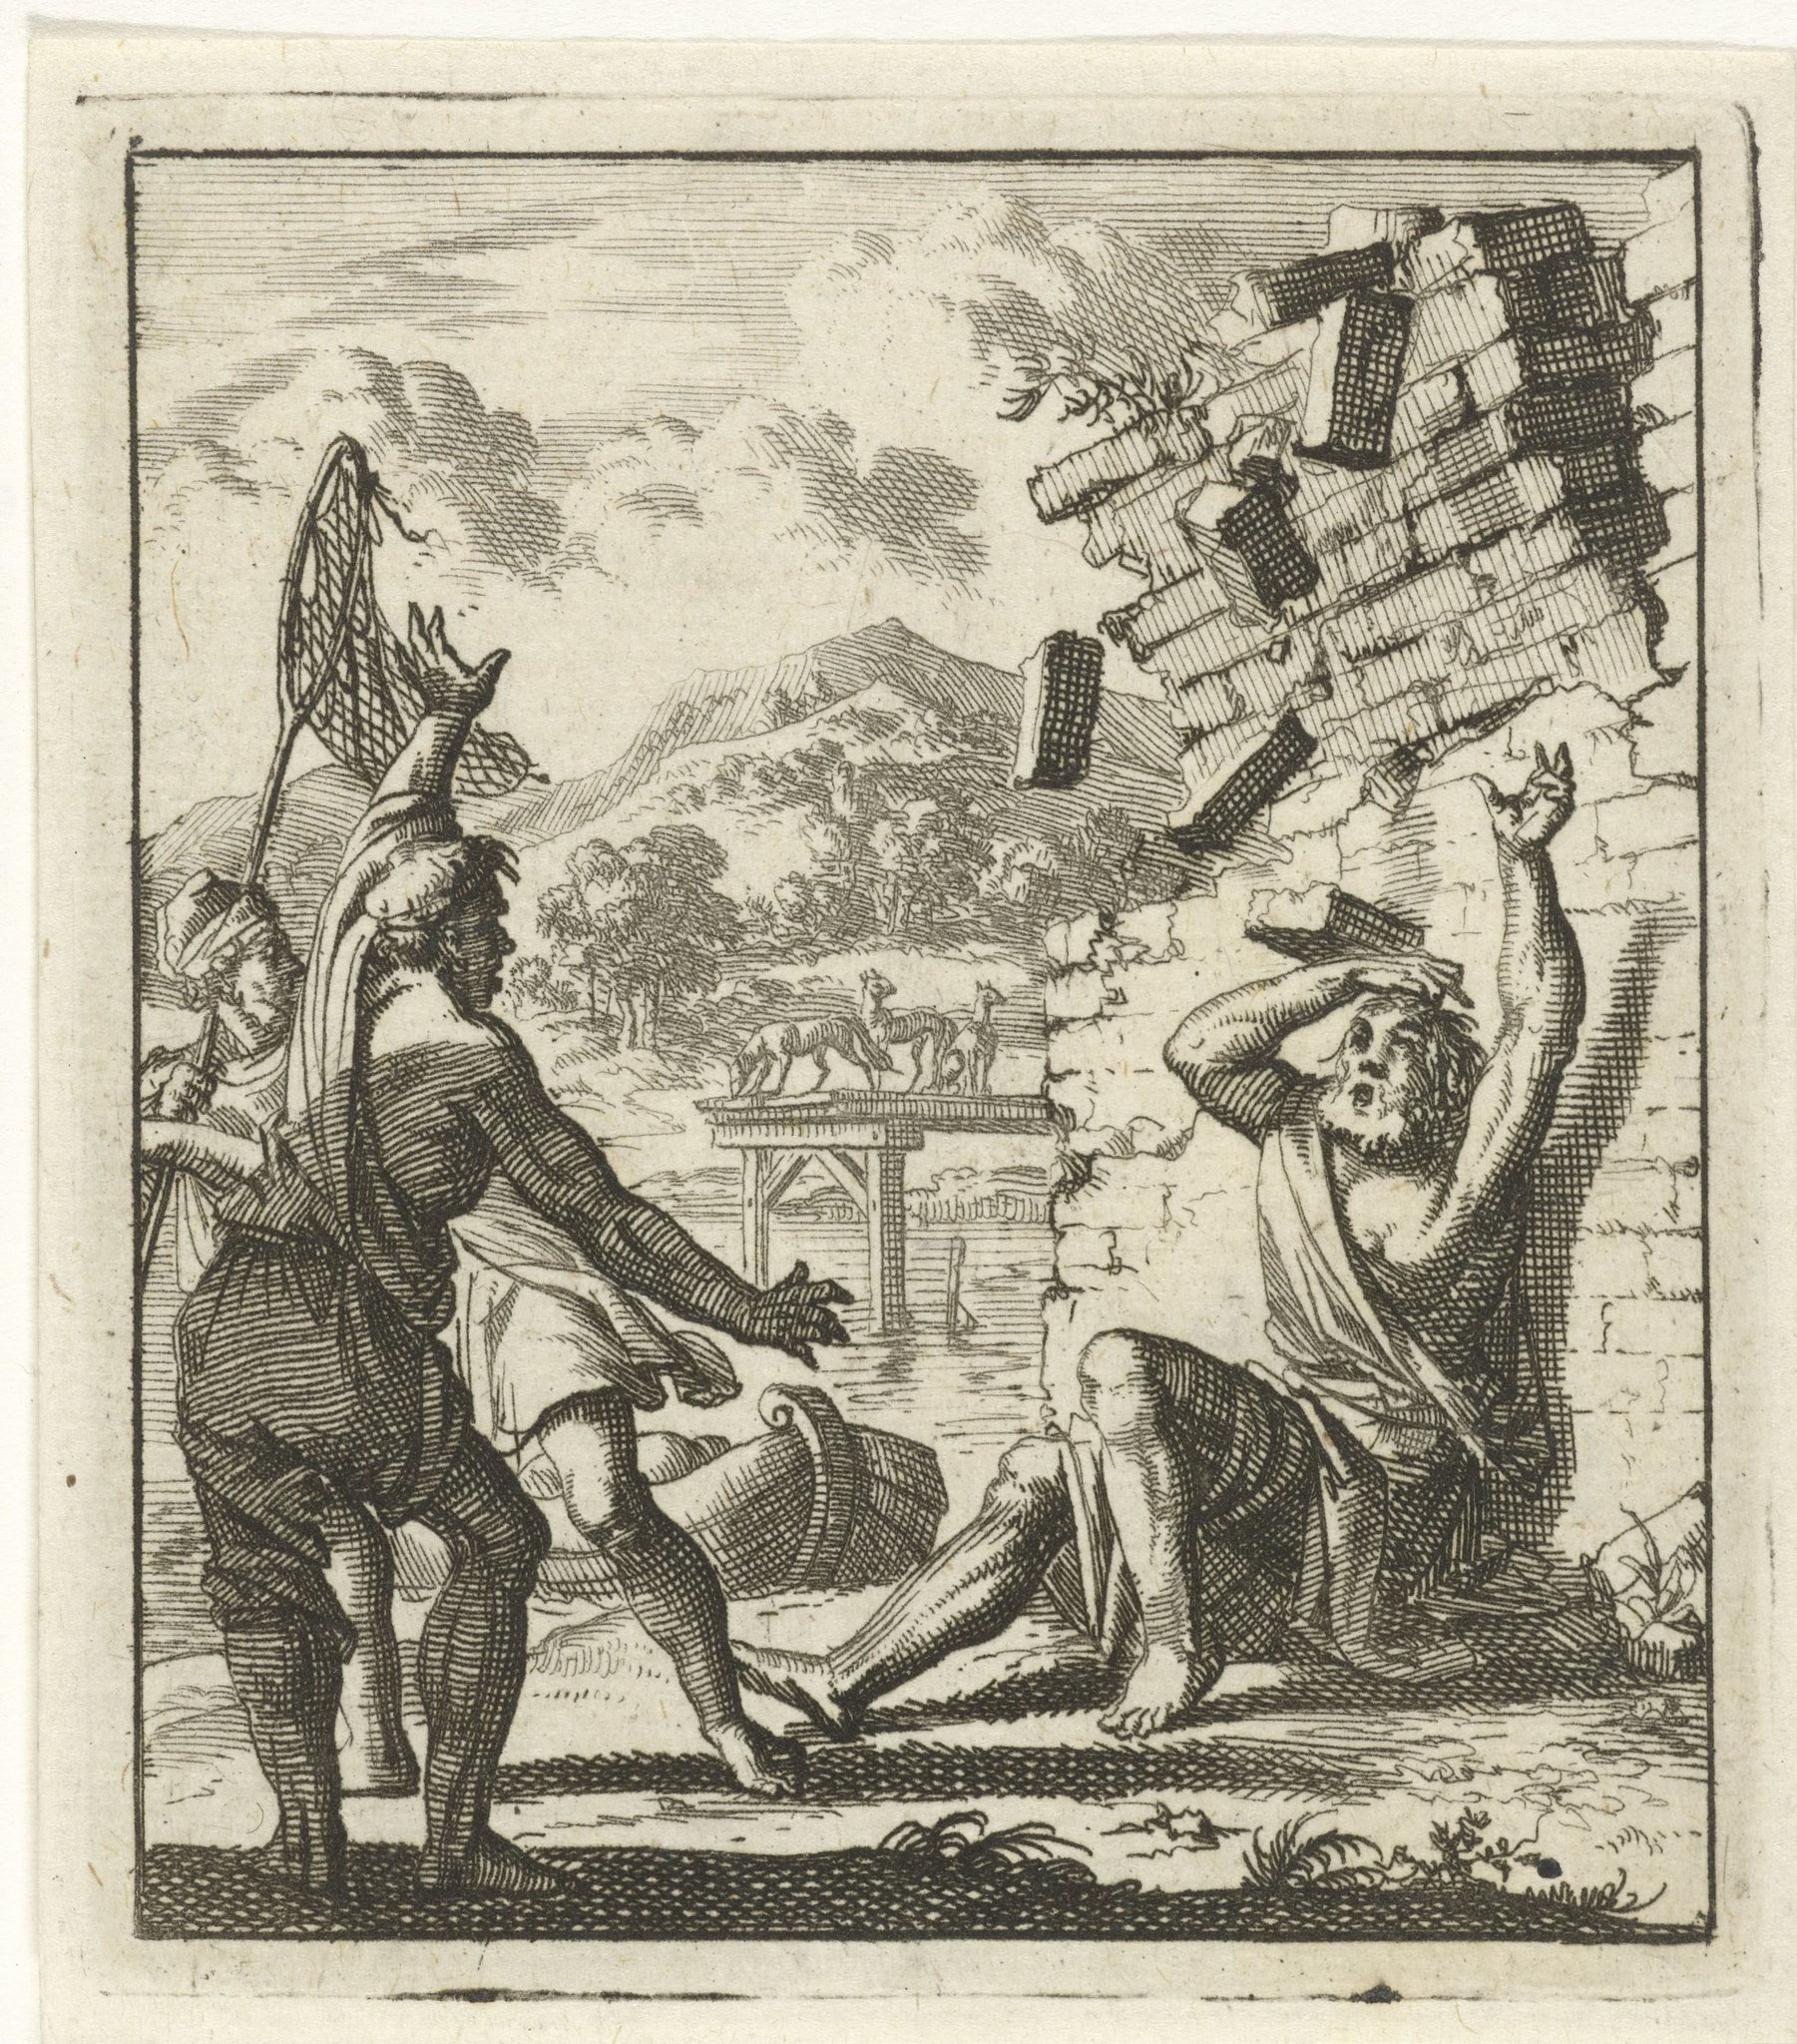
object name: print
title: Man wordt door instortende muur verpletterd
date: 1693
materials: paper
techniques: etching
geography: amsterdam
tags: collapsing building, fisherman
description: Illustratie uit: Duĳkerius, Johannes. Voorbeeldzels der oude wyzen. Waar in (...) de menschelijke hartstogten (...) behandeld worden. Amsterdam: Aart Wolsgrein, 1693, p. 31.